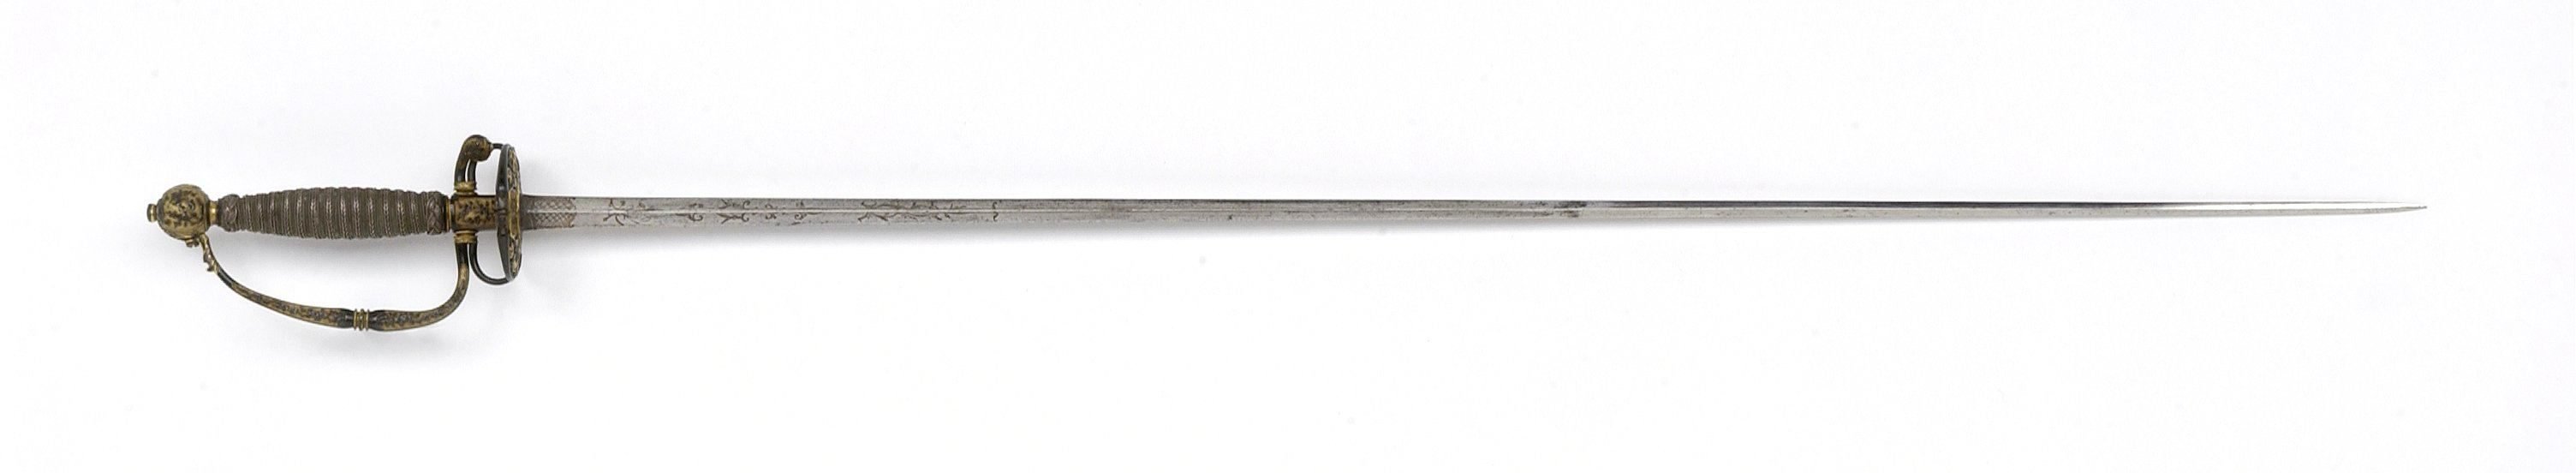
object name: small sword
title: Sierdegen met een gevest gemonteerd in sawasa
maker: Anonymous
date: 1700-1725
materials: silver, steel, wood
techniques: casting, embroidery, etching, gilding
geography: japan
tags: japan